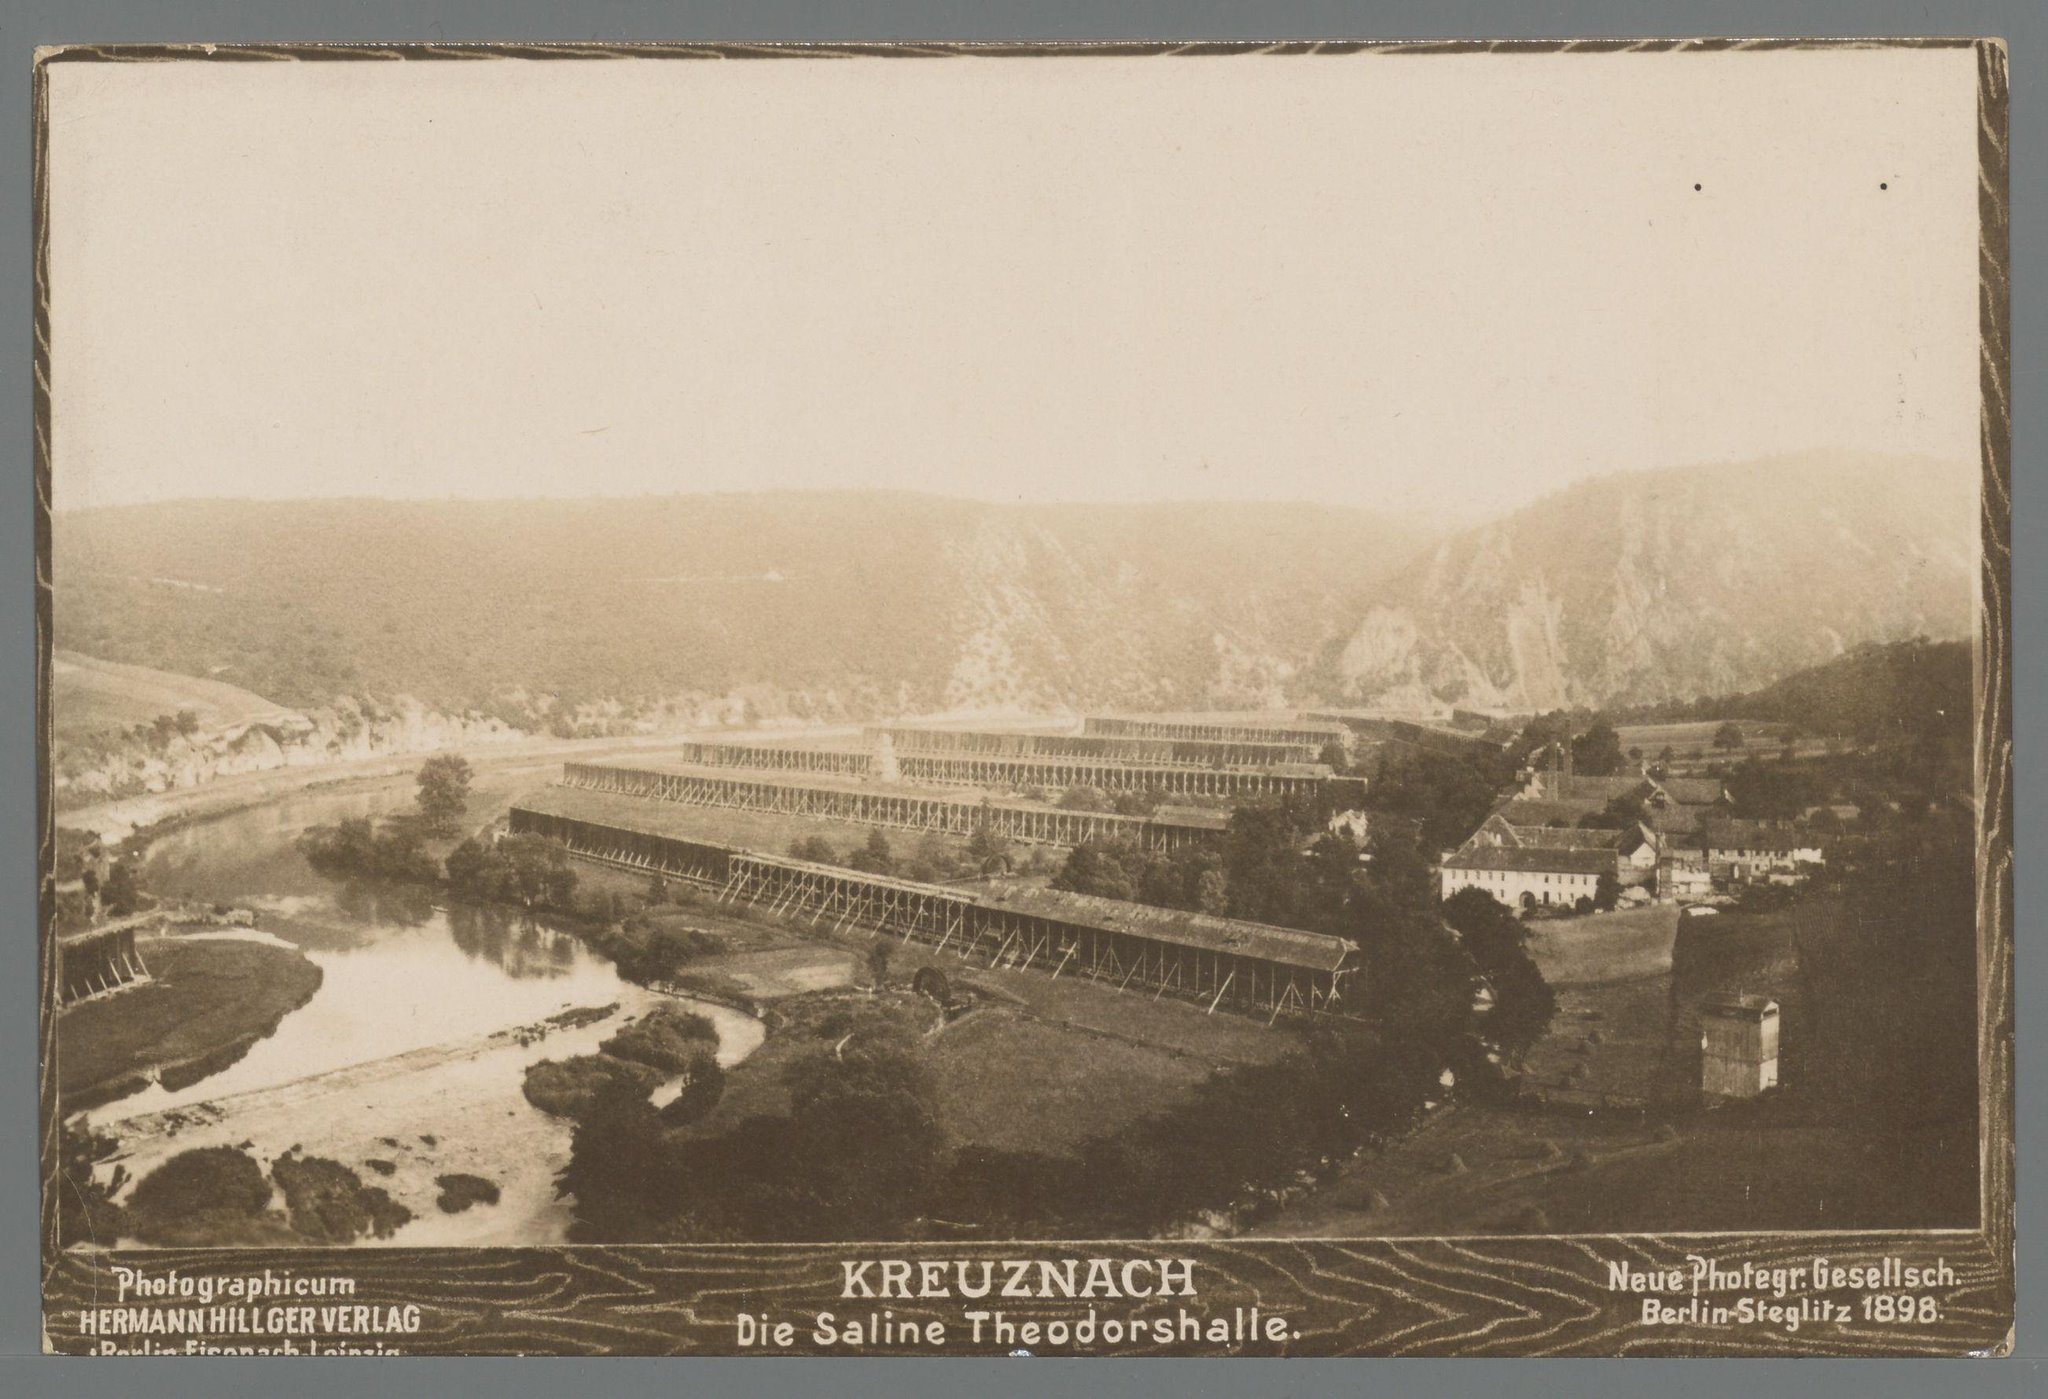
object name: ansichtkaart, prentbriefkaart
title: Kreuznach. Die Saline Theodorshalle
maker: hermann hillger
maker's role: fotograaf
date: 1898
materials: photographic support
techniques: gelatin silver print, writing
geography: steglitz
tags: park, canals, waters (in city), advertisement, notice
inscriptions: date